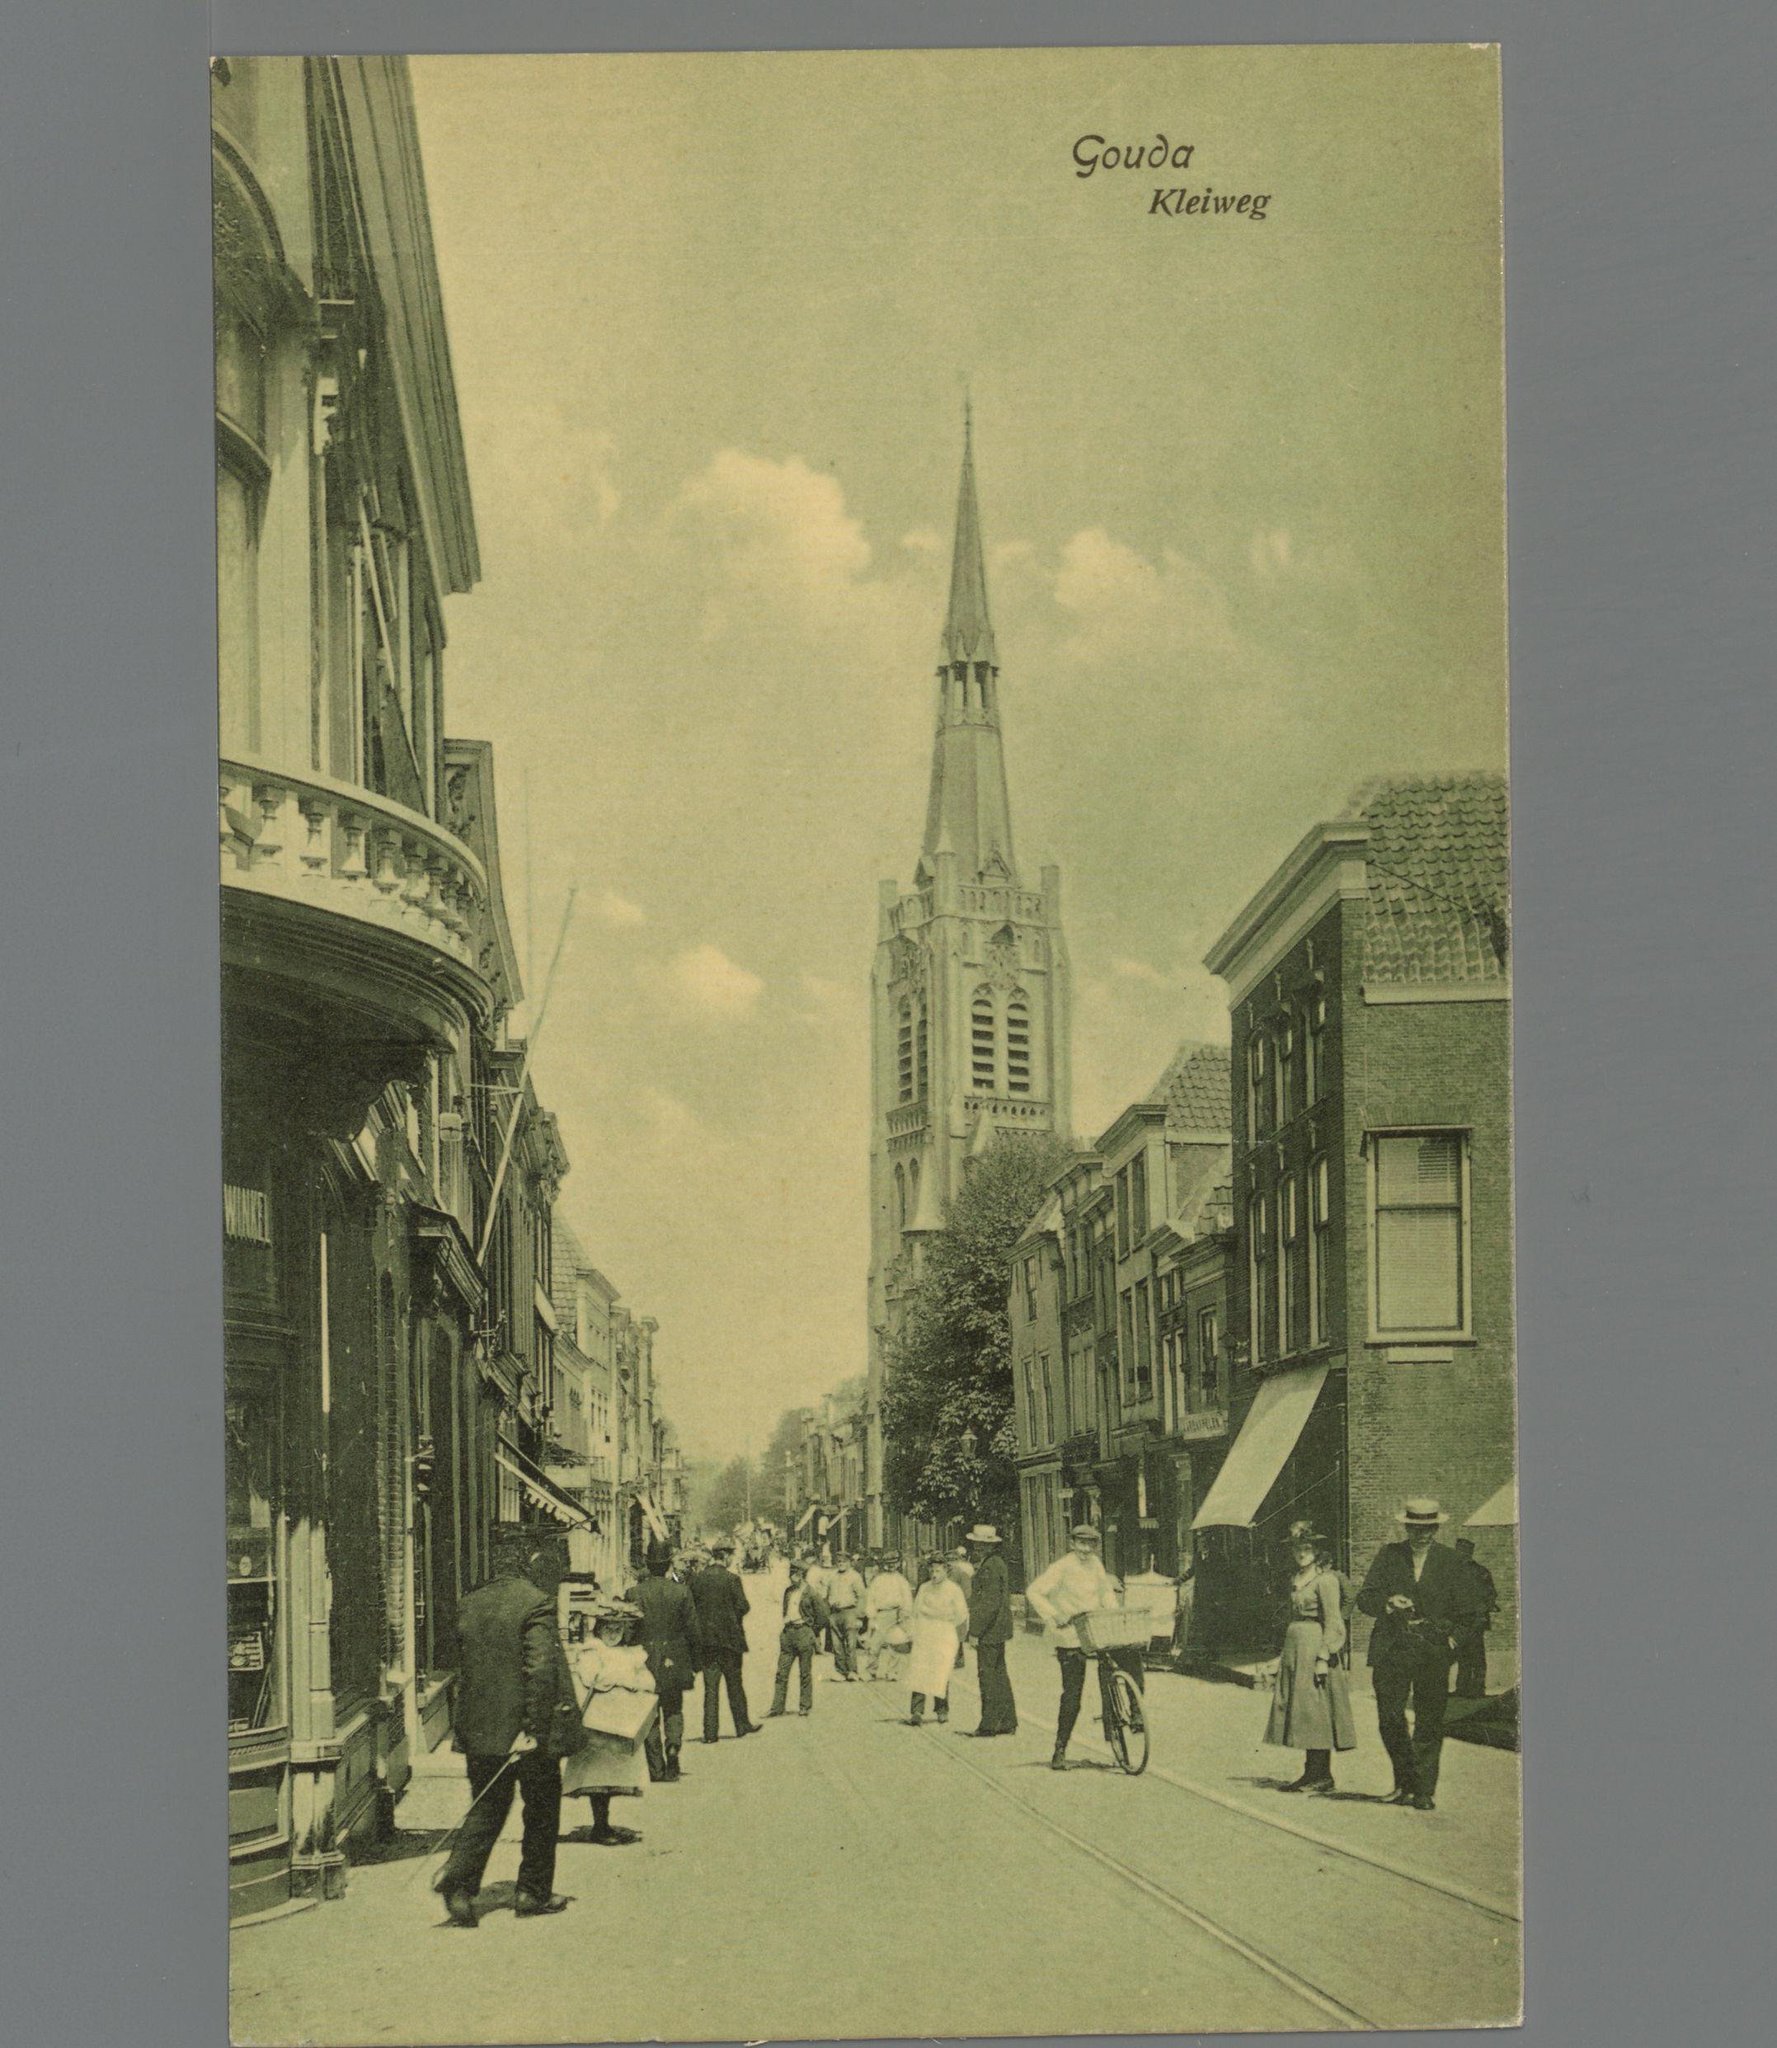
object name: photomechanical print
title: Gouda. Kleiweg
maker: Anonymous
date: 1908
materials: cardboard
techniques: photograph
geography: gouda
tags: church (exterior), street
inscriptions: date